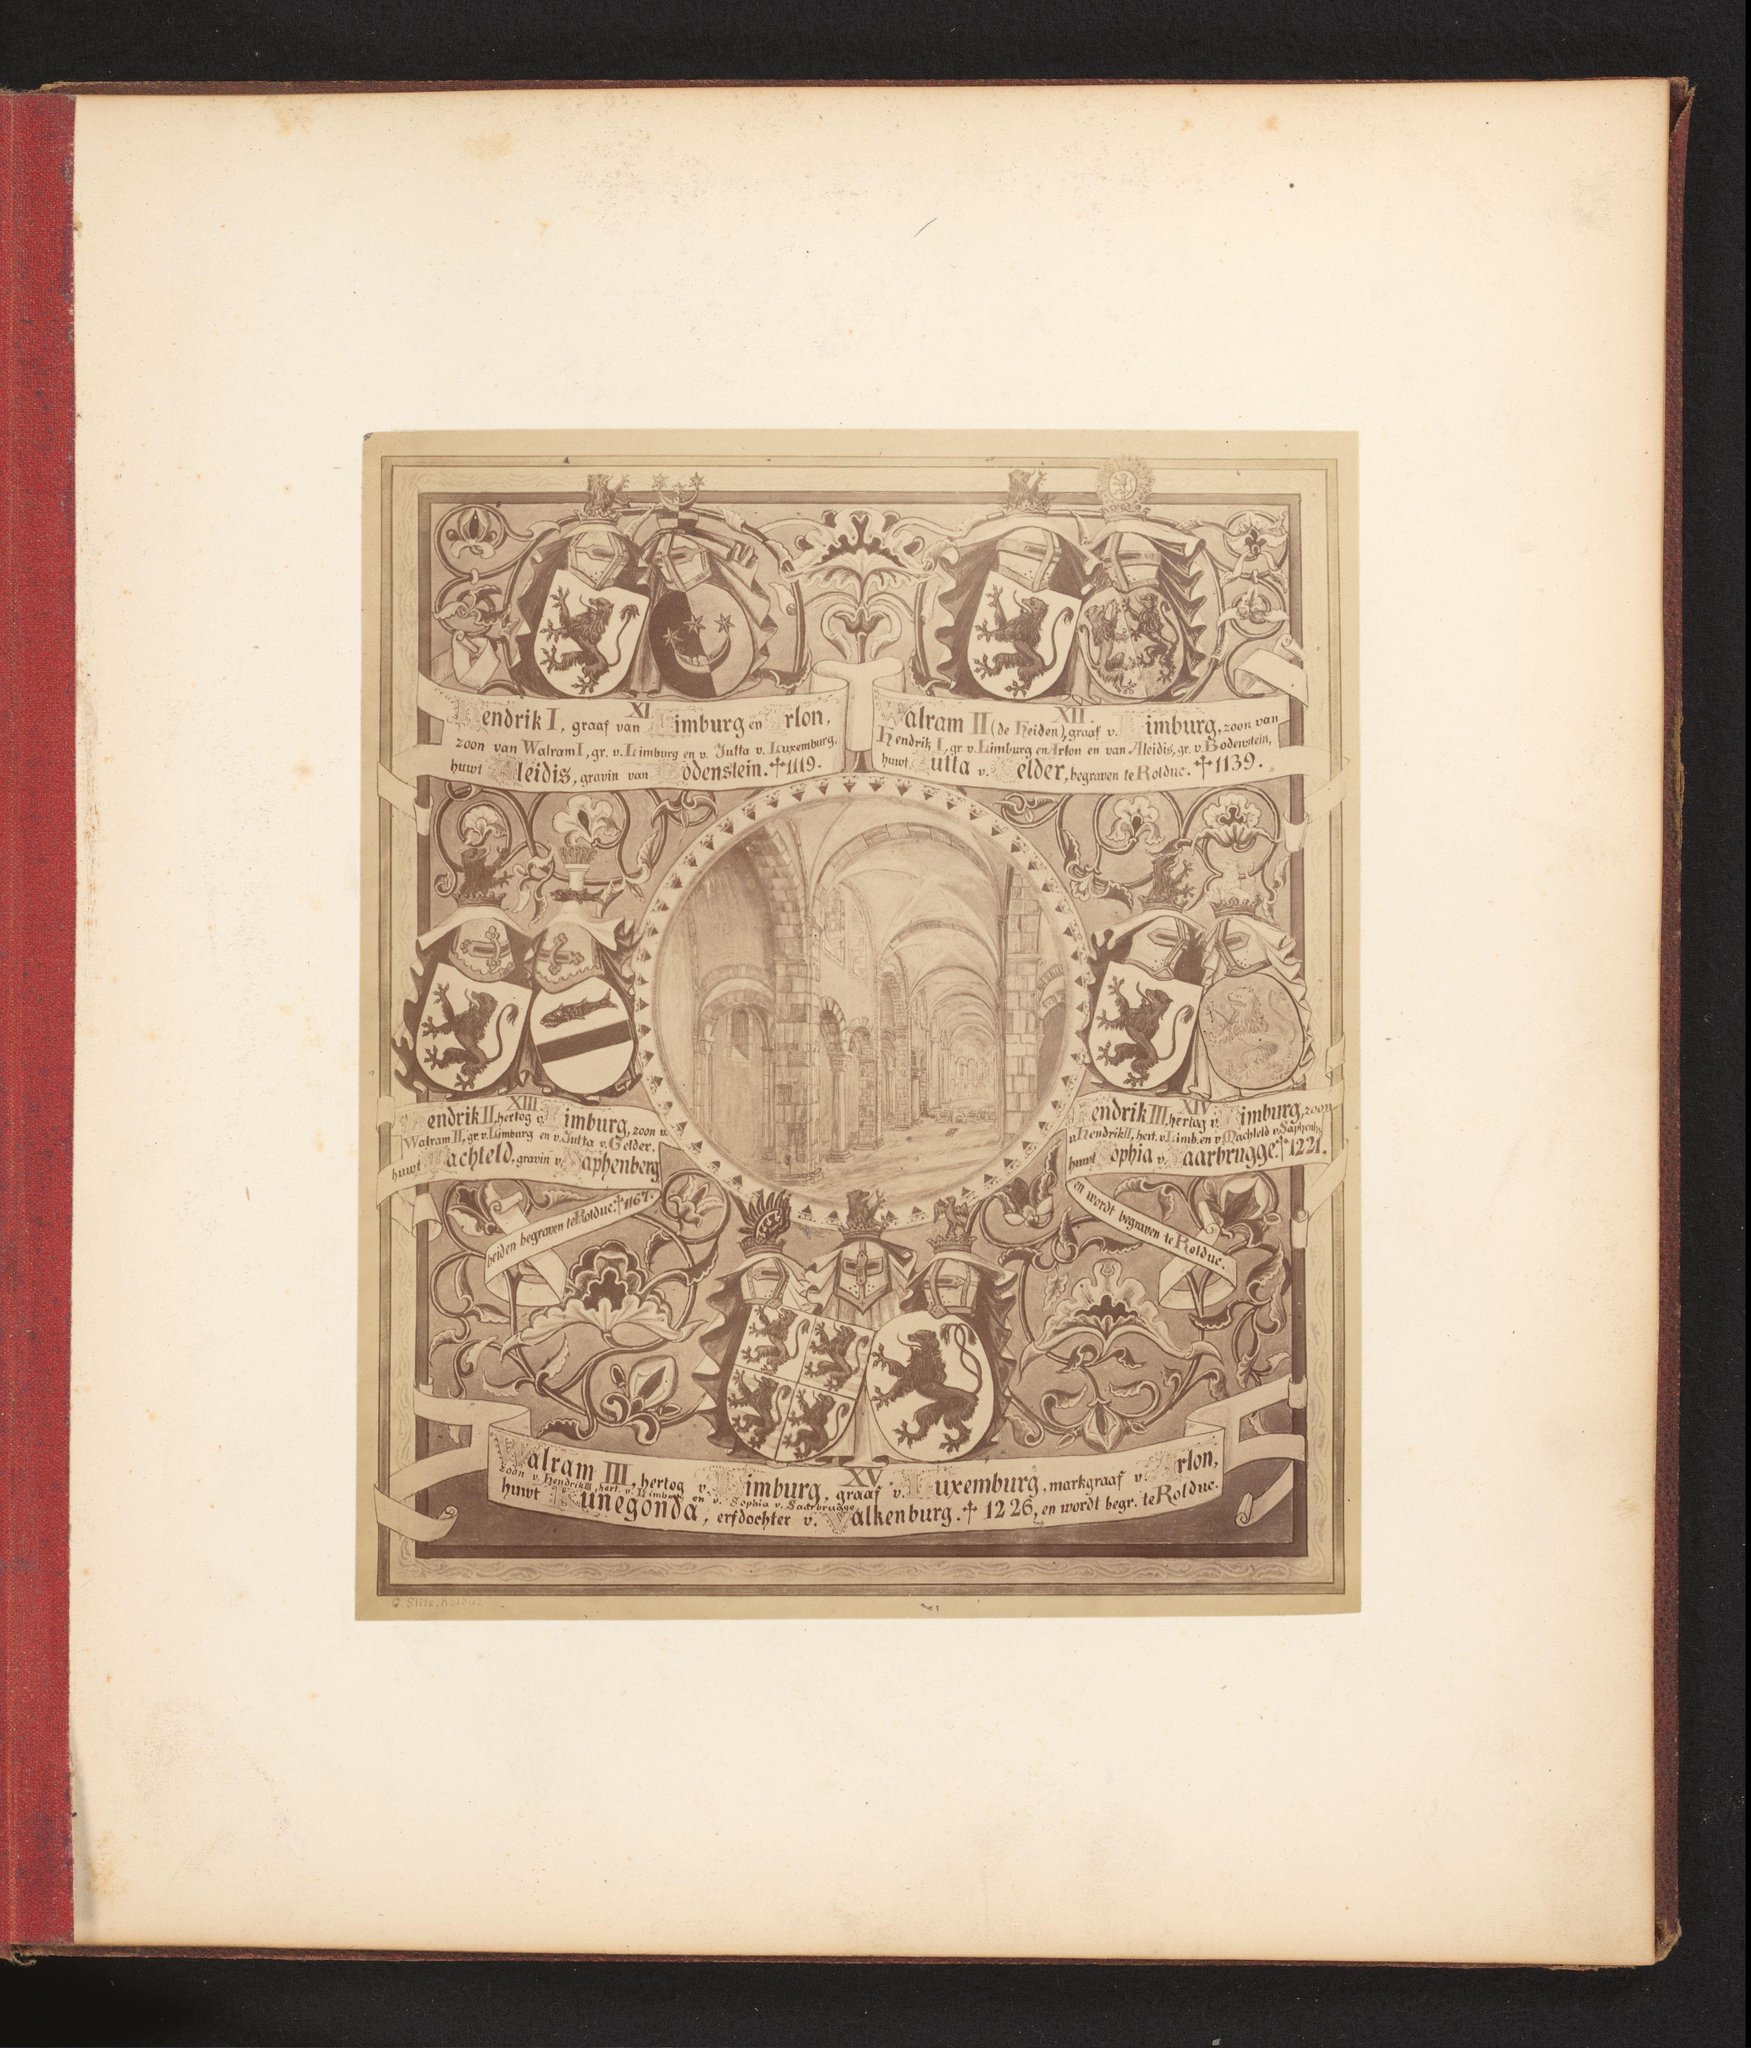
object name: photograph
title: Fotoreproductie van een tekening van een stamboom, van Hendrik I, graaf van Limburg, tot Walram III, graaf van Limburg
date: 1869-1874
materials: cardboard, paper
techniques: albumen print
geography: rolduc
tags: family lineage, pedigree, genealogical tree or table, series of rulers